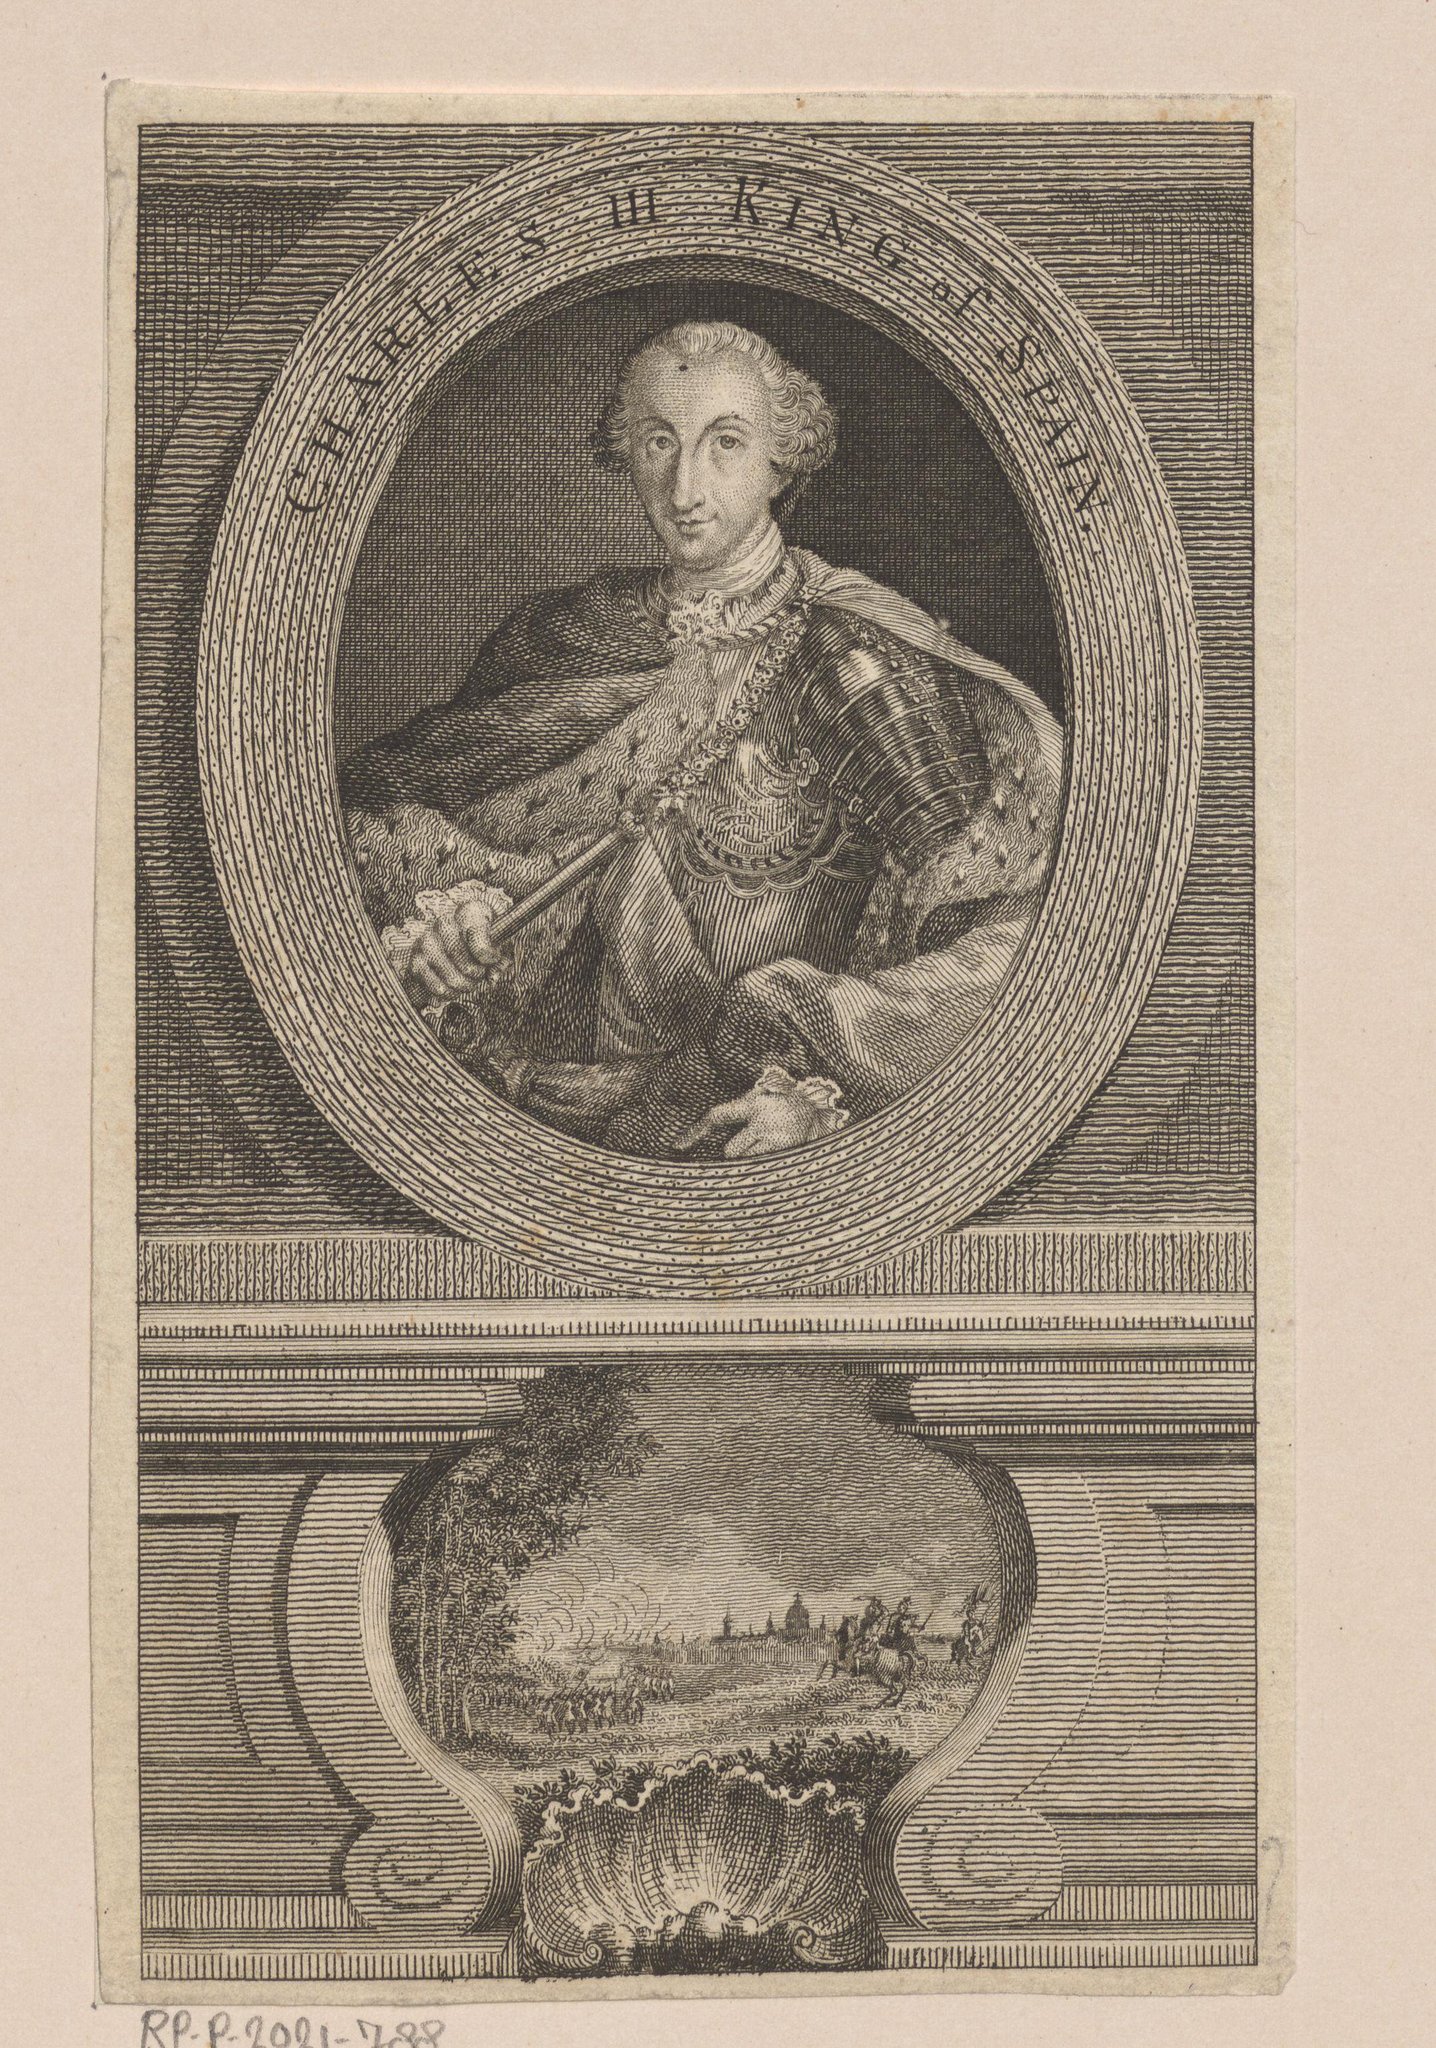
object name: print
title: Portret van Karel III, koning van Spanje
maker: Anonymous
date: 1780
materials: paper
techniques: engraving, etching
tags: karel iii (koning van spanje (1716-1788), historical persons, knighthood order of the golden fleece, war, king